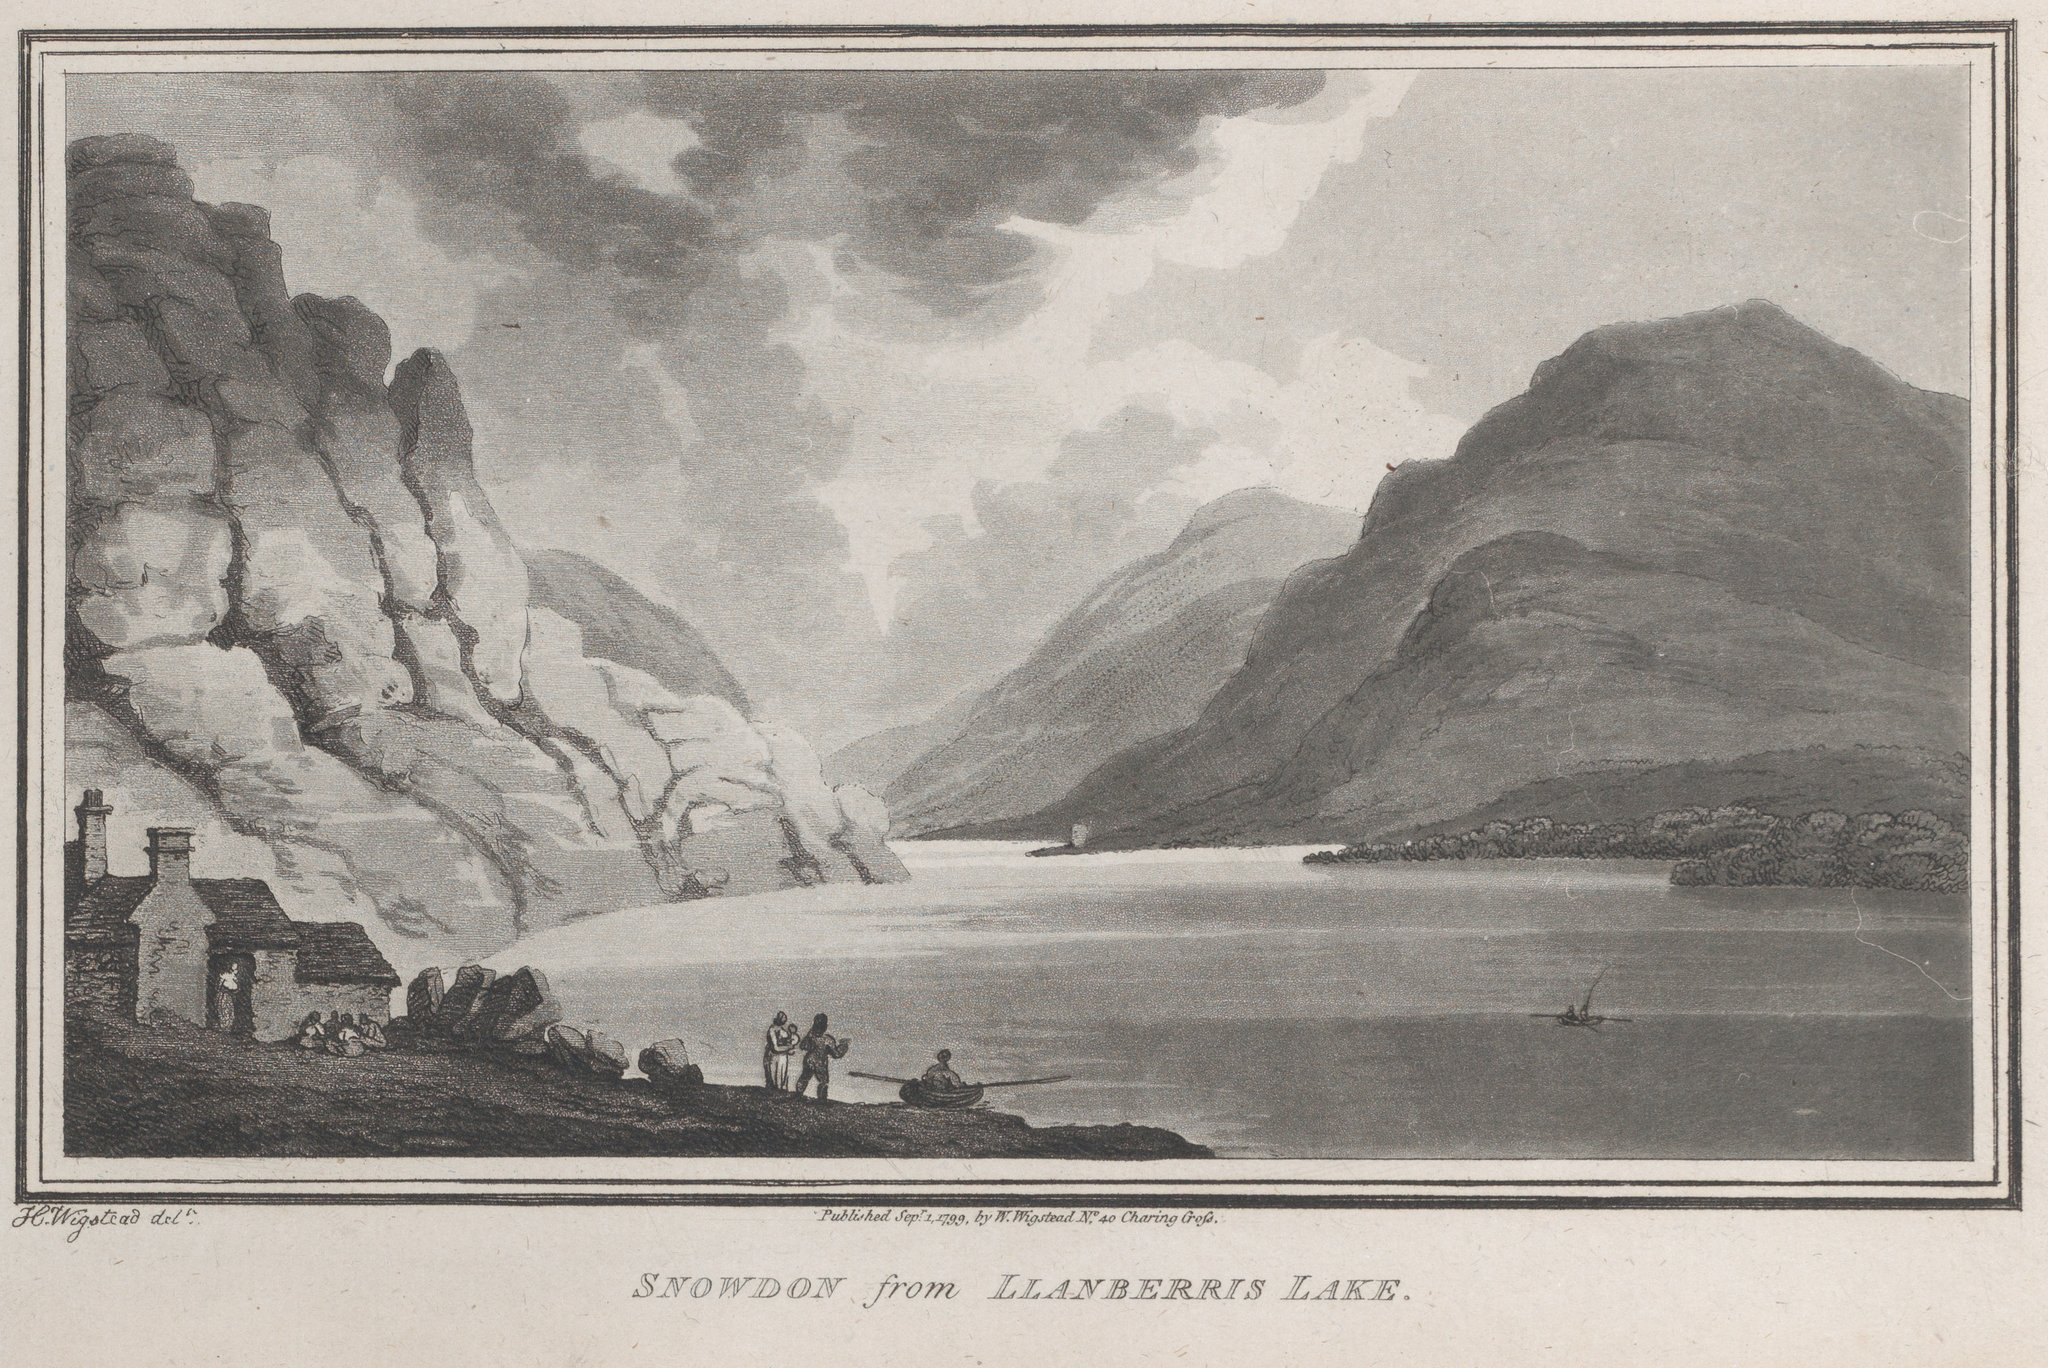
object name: print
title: Snowdon from Llanberris Lake, from "Remarks on a Tour to North and South Wales, in the year 1797"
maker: john hill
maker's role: artist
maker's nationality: british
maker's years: 1714-1775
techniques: aquatint, etching